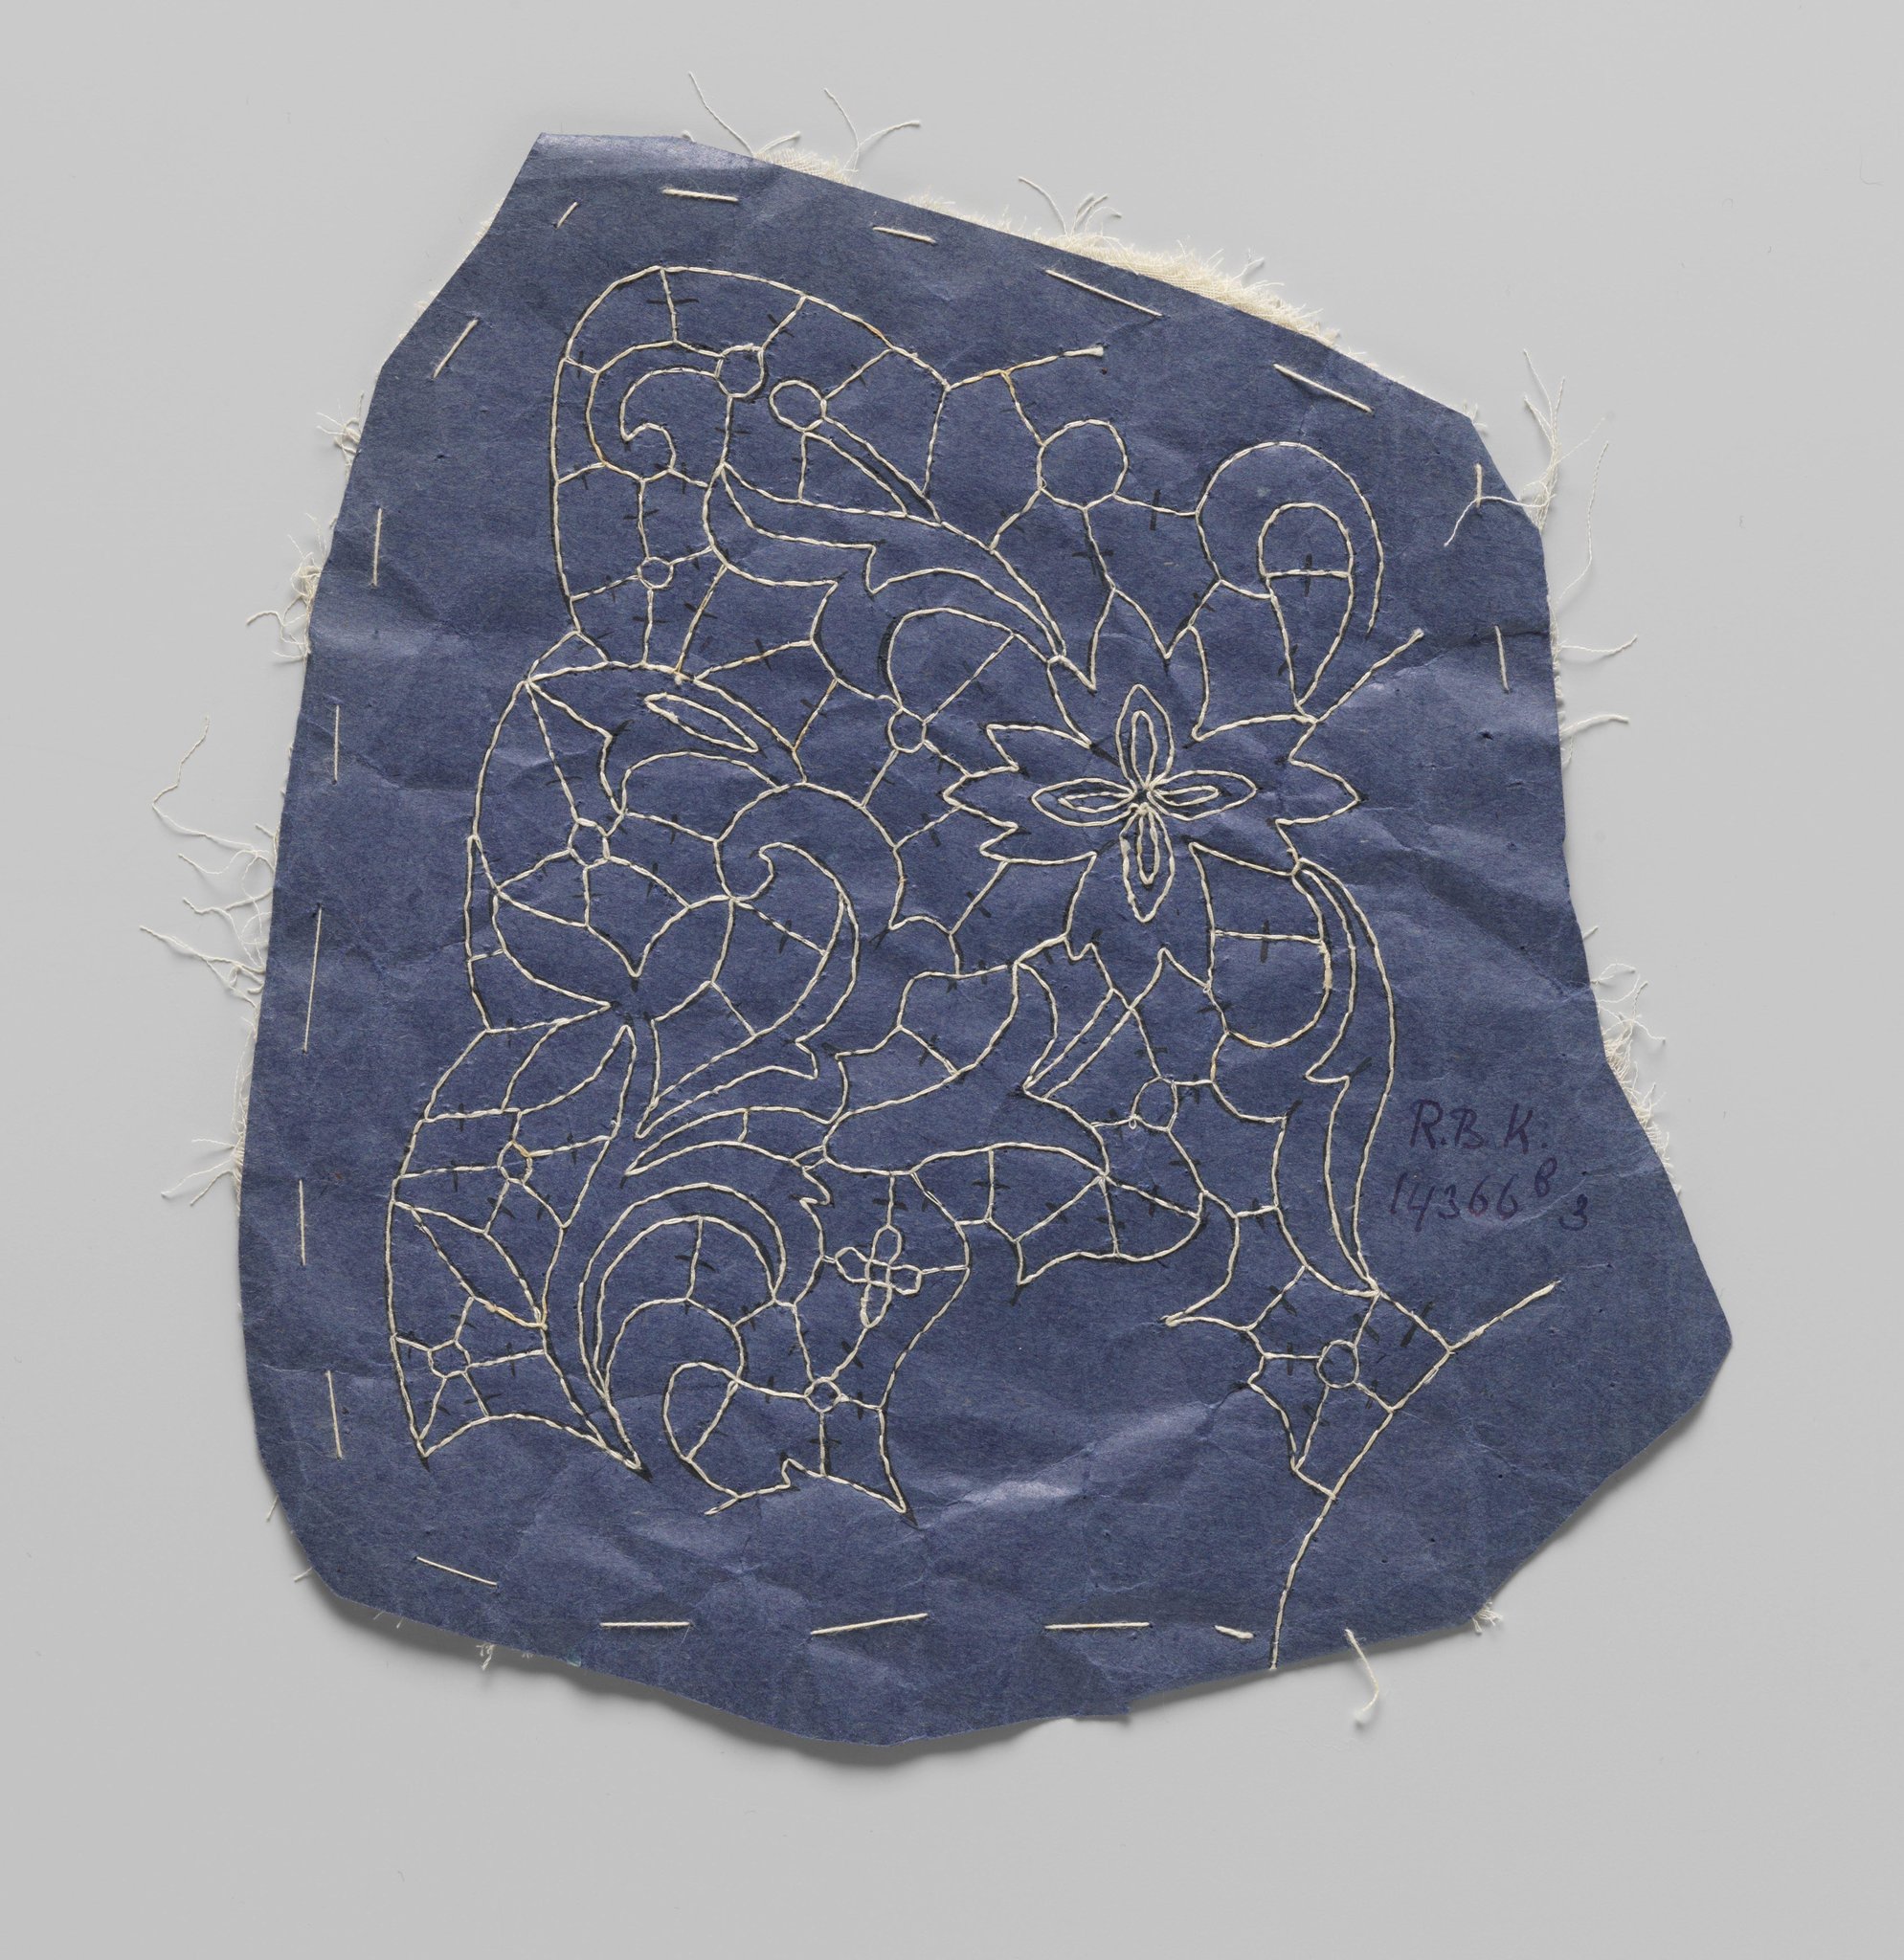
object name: lace pattern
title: Prikking vastgeregen op een dubbele lap katoen en met traceerdraden voor het maken van een deel van een kraag van naaldkant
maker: johanna e. van nierop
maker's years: 1882-1970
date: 1915-1924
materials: cotton, paper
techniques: sewing, needlepoint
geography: amersfoort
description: Prikking voor een deel van een kraag van Venetiaanse naaldkant. Het naaldkantpatroon is met inkt getekend op blauw papier en langs de patroonlijnen zijn vervolgens gaatjes geprikt. Door deze 'prikking' en de dubbele laag katoen is een traceerdraad genaaid. Als de naaldkantsteken over en tussen de traceerdraden gemaakt zijn kan de prikking en de katoenen ondergrond worden losgeknipt en verwijderd. Dan hou je alleen naaldkant over, in dit geval een deel van de kraag die dan met de andere delen en de rand tot kraag kan worden verwerkt. Het ontwerp van de kraag is gemaakt door een persoon uit België die in de Eerste Wereldoorlog was geïnterneerd in kamp 'Elisabeth-dorp' in Amersfoort. Mevrouw van Nierop is begonnen met het maken van de kraag en heeft de onafgewerkte delen geschonken aan het Rijksmuseum als studiemateriaal.